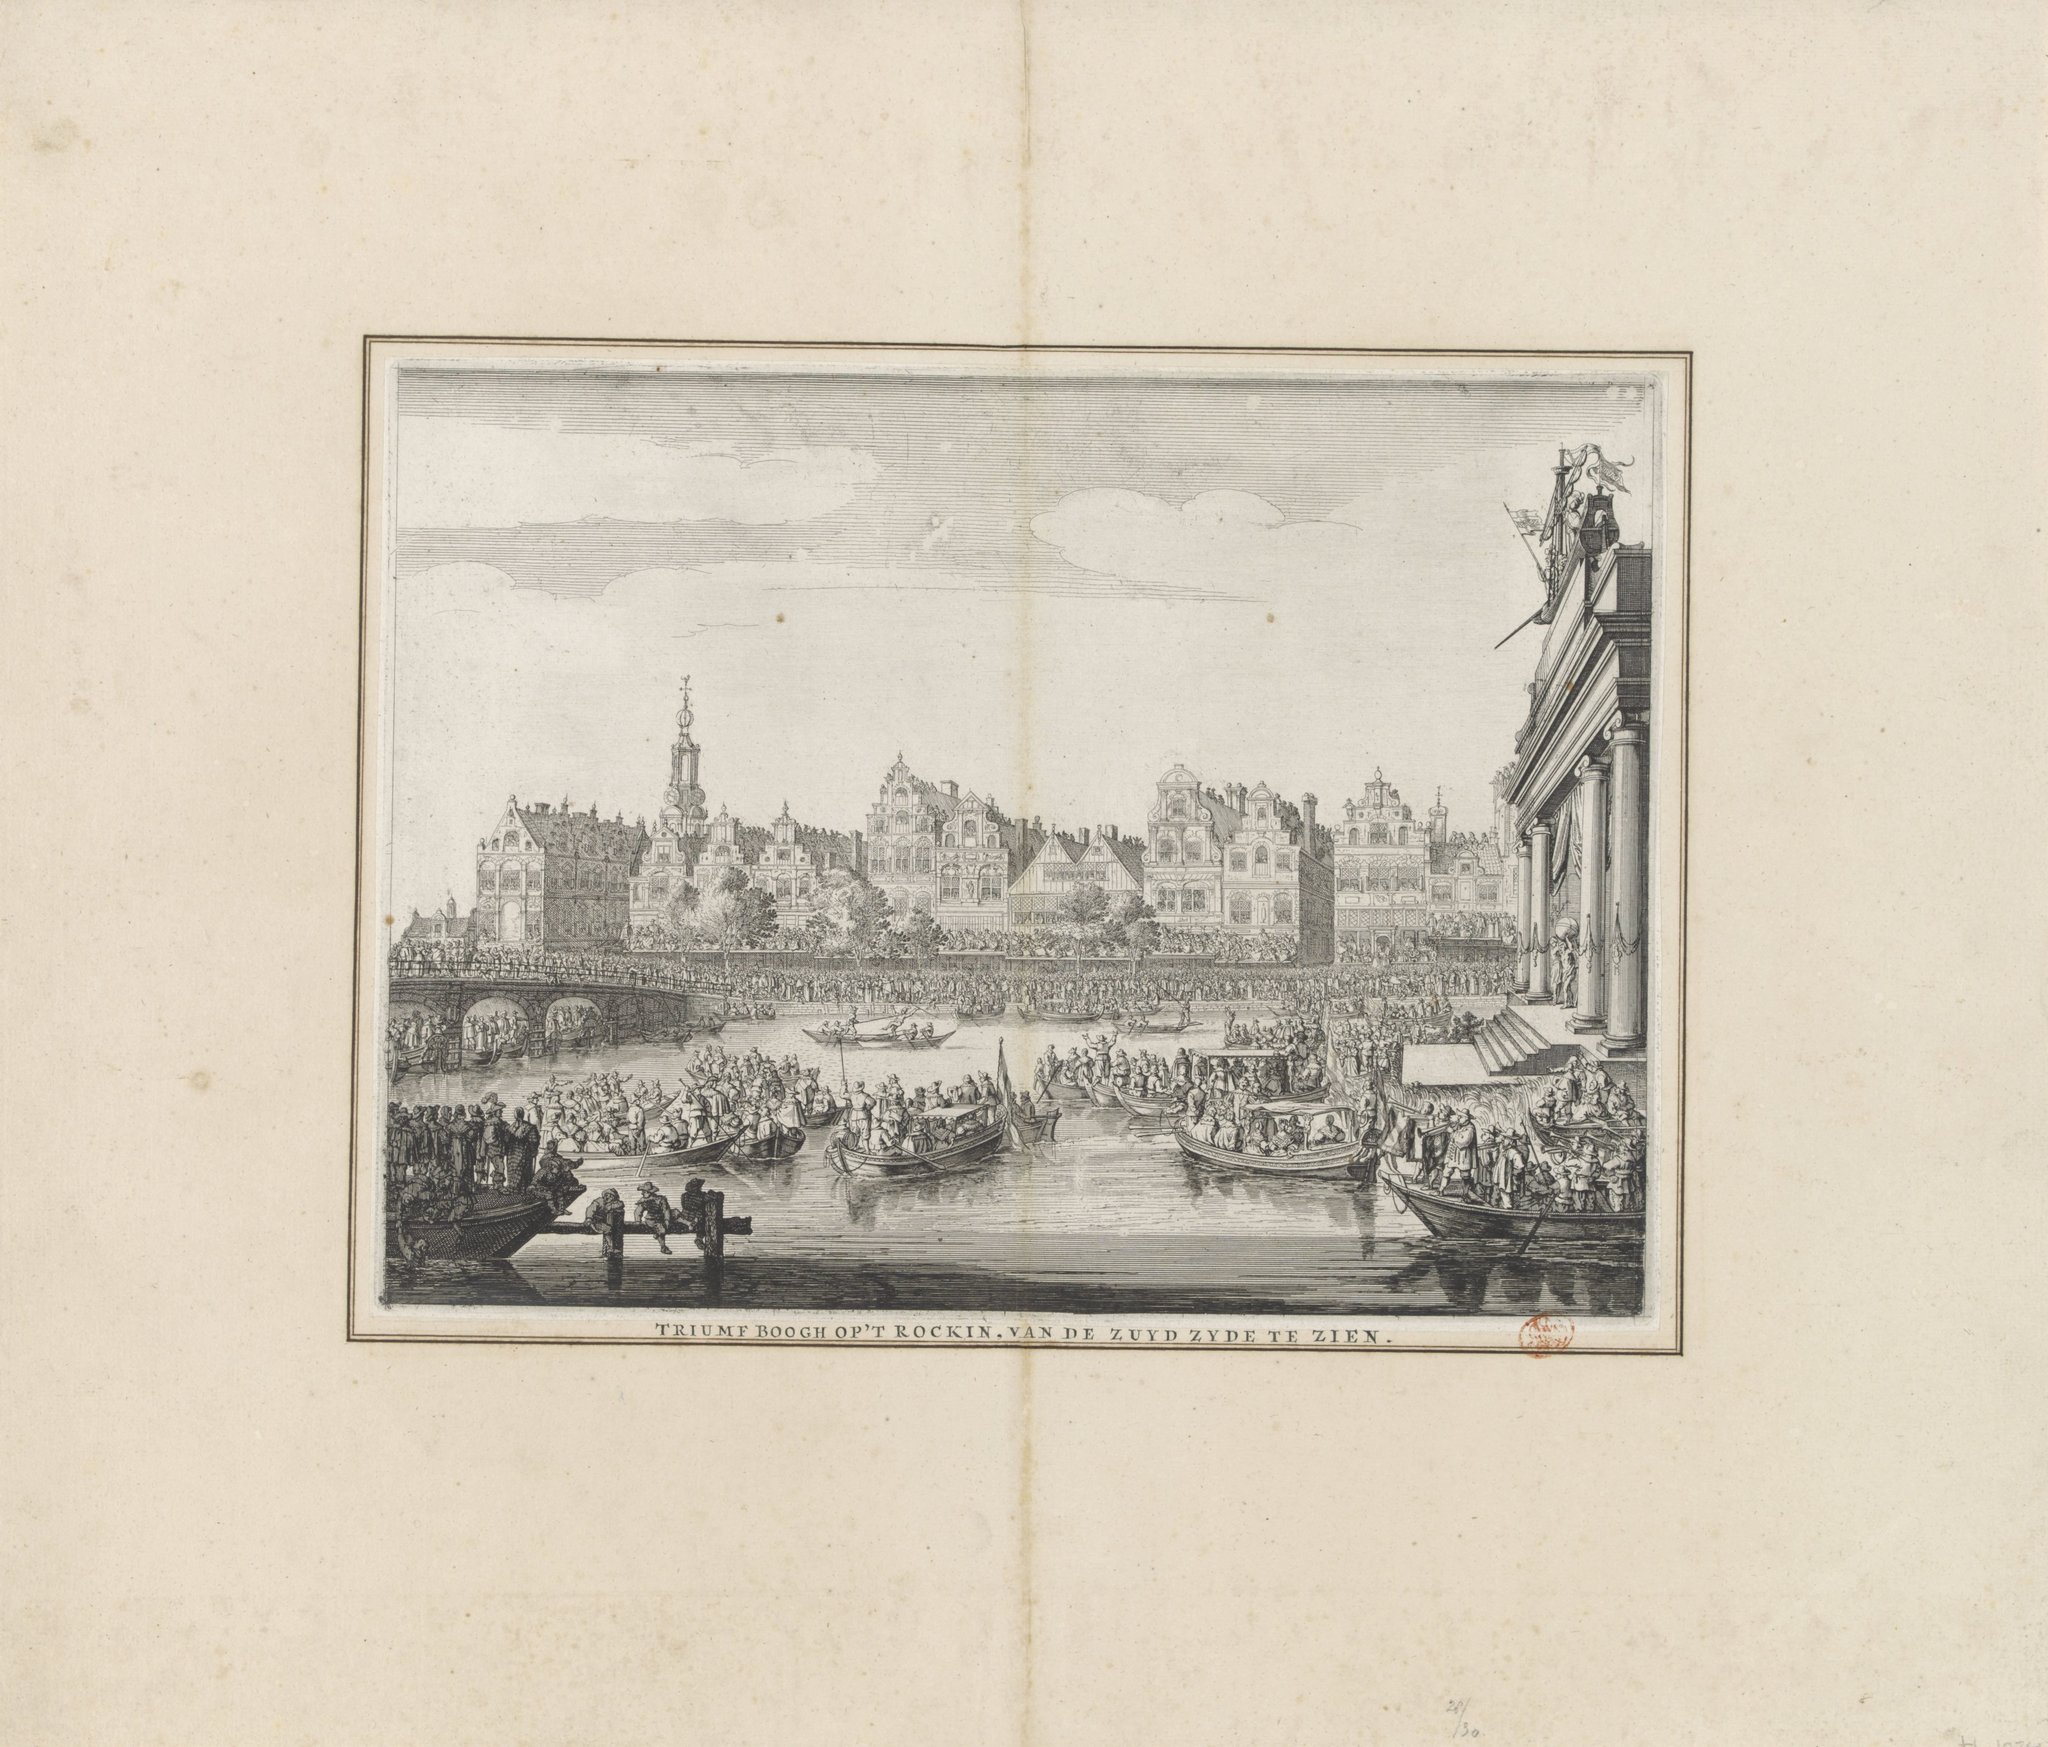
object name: print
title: Steekspel in boten bij het drijvende theater op het Rokin, 1638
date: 1638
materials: ink, paper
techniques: etching, pen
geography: amsterdam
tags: print maker, maria de' medici, coat of arms (as symbol of the state, etc.) (+ city; municipal), sports, etc. in and on the water, tournament, triumphal entry and public reception, pageant, 'entrée solennelle', 'joyeuse entrée'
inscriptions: inscription: ‘Triumf Boogh op 't Rockin, van de zuyd zyde te zien.’, collector's mark: Lugt 195, collector's mark: Lugt 2228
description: Prent ook gebruikt in:* Baerle, Caspar van. Medicea hospes, sive descriptio publicae gratulationis, qua Serenissimam, Augustissimamque Reginam, Mariam de Medicis (…). Amsterdam: Johannes en Cornelis Willemsz. Blaeu, 1638. En in: Baerle, Caspar van. Marie de Medicis, entrant dans Amsterdam : ou, histoire de la reception faicte à la Reyne Mere du Roy tres-Chrestien (…). Amsterdam: Johannes en Cornelis Willemsz. Blaeu, 1638. En in: Baerle, Caspar van en Joost van den Vondel. Blyde inkomst der allerdoorluchtighste koninginne, Maria de Medicis t' Amsterdam. Vertaelt uit het Latijn (…). Amsterdam: Johannes en Cornelis Willemsz. Blaeu, 1639. * Doorgaans zijn de prenten in de bovengenoemde publicaties rechtsonder genummerd (van de huidige prent is dat de derde bekende staat). Maar er zijn ook exemplaren waarin eerdere, ongenummerde, staten van de prenten (van de huidige prent de eerste en tweede bekende staat) zijn ingebonden.